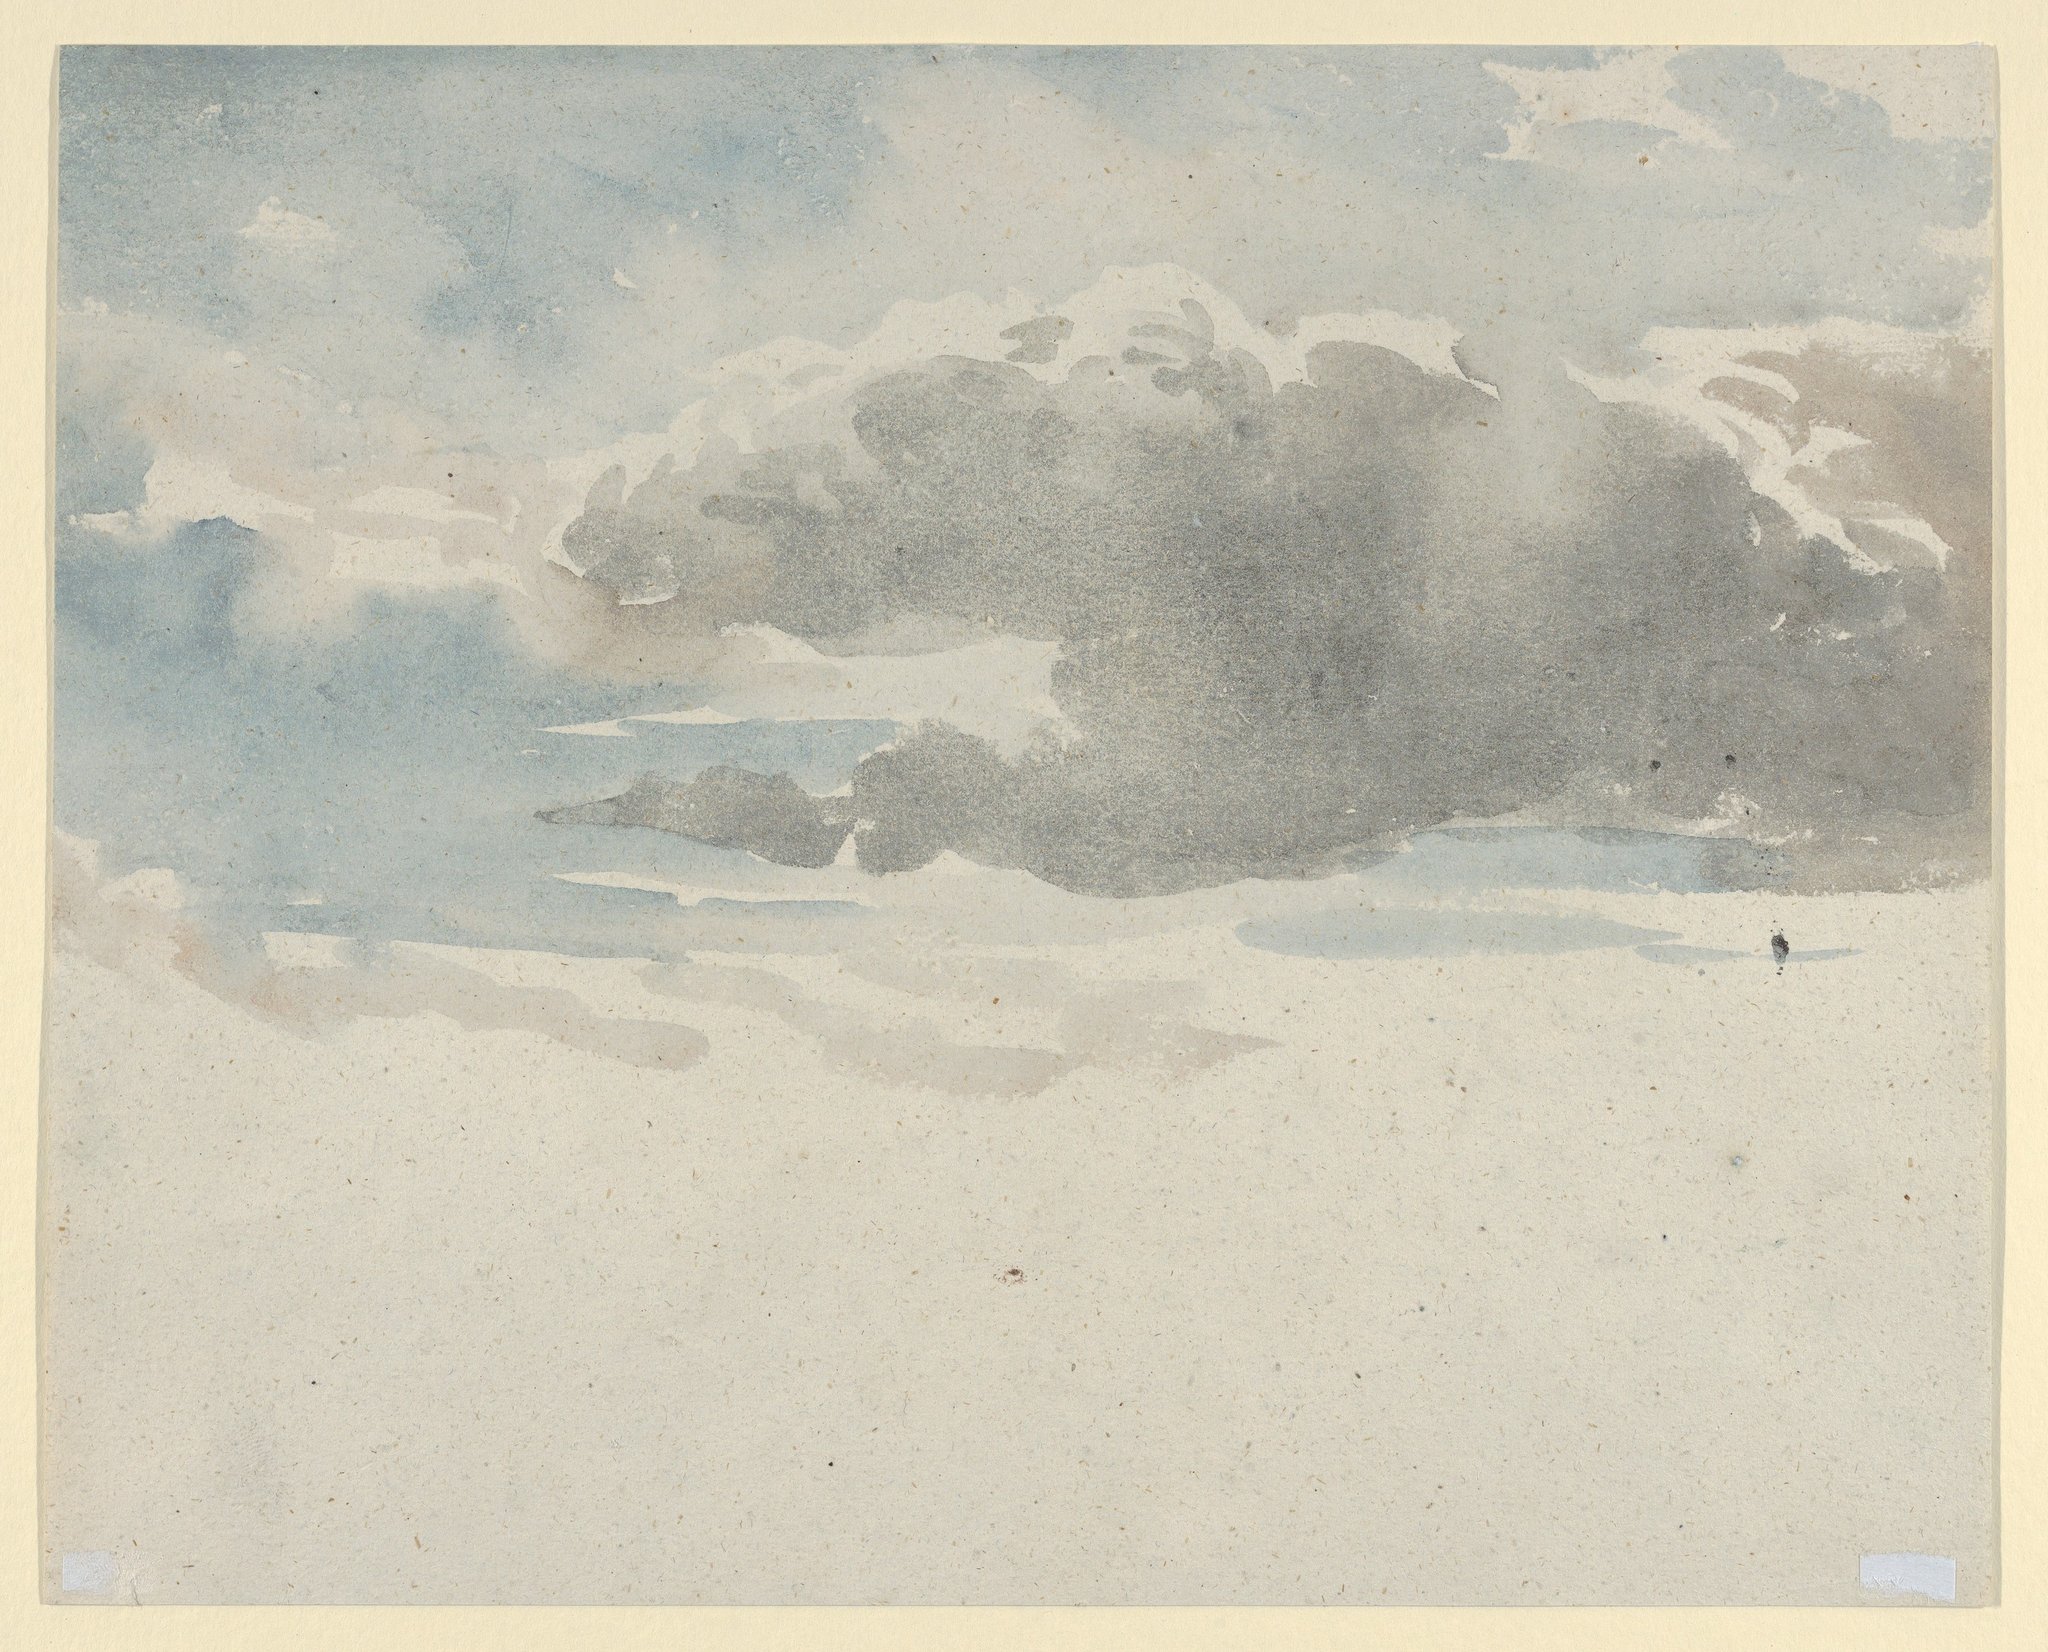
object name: drawing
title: Study of clouds (recto). Study of an elder bush by a fence (verso)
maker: david cox, the elder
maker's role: artist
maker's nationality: english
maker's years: 1783-1859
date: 1820-1845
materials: graphite, watercolor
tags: clouds